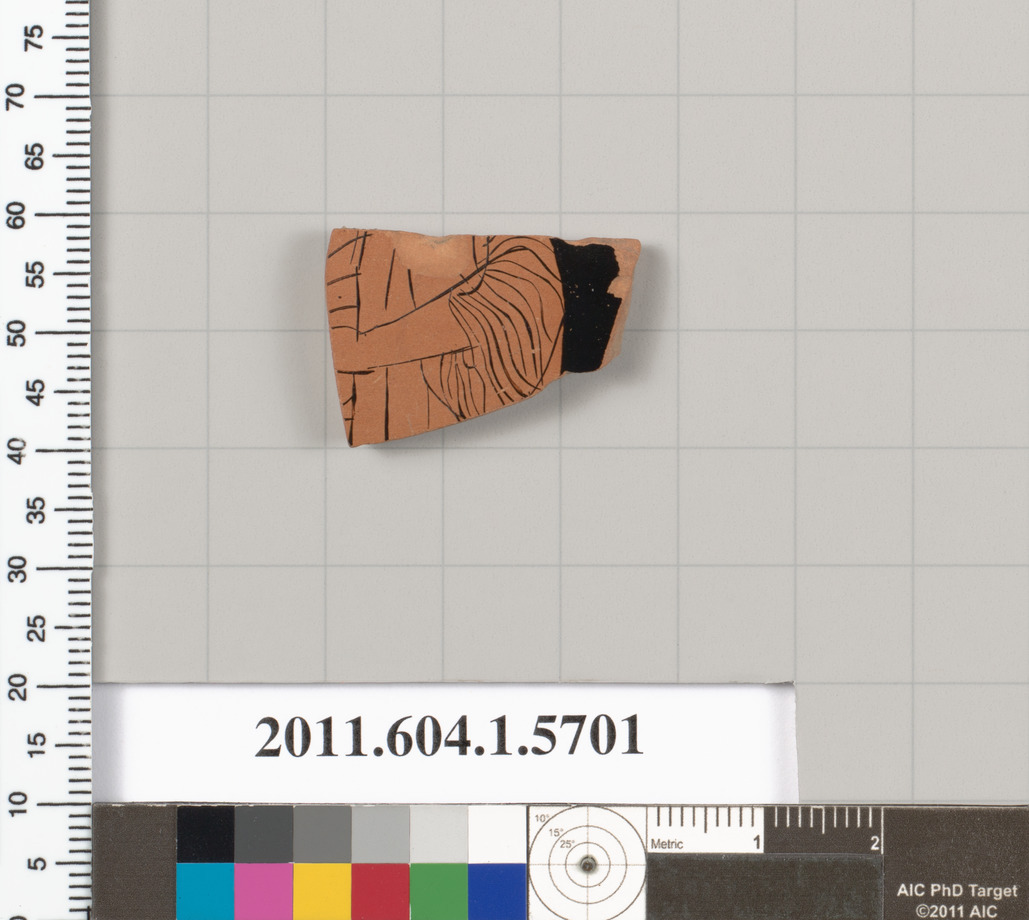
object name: kylix fragment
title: Terracotta fragment of a kylix (drinking cup)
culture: greek, attic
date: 490-470 BCE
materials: terracotta